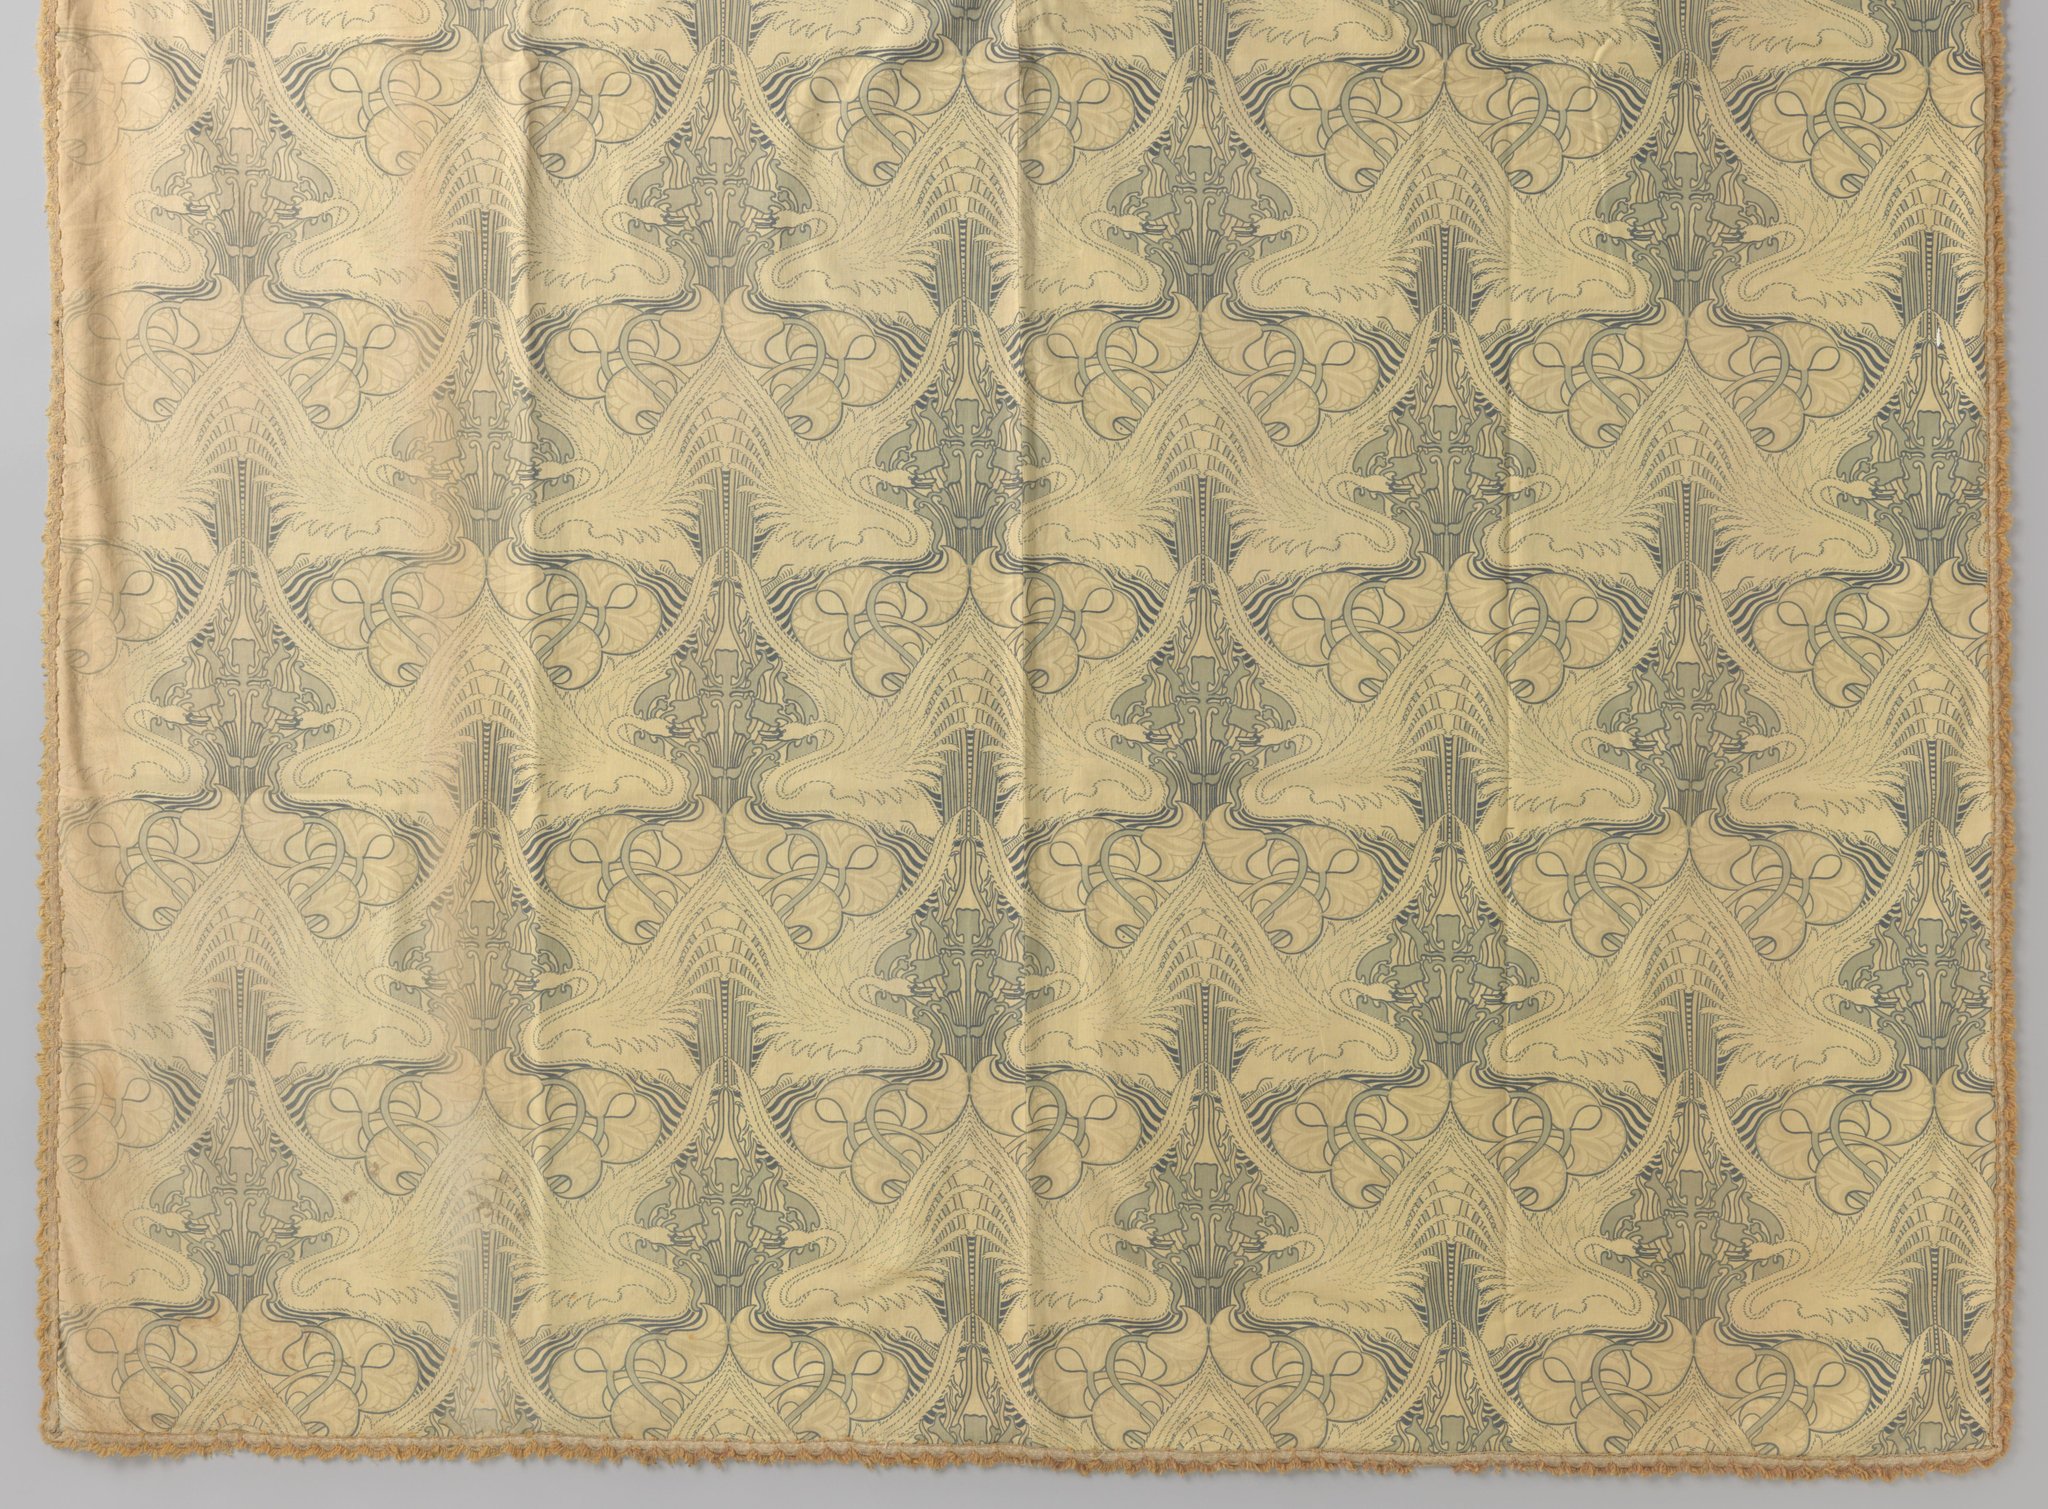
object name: curtain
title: Deurgordijn van bedrukte cretonne met zwanen en lissen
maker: michiel duco crop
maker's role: designer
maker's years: 1862-1901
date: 1900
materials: linen, metal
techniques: printing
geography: helmond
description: Deurgordijn van bedrukte cretonne met zwanen en lissen en aan drie zijden voorzien van passement en met metalen ringen.